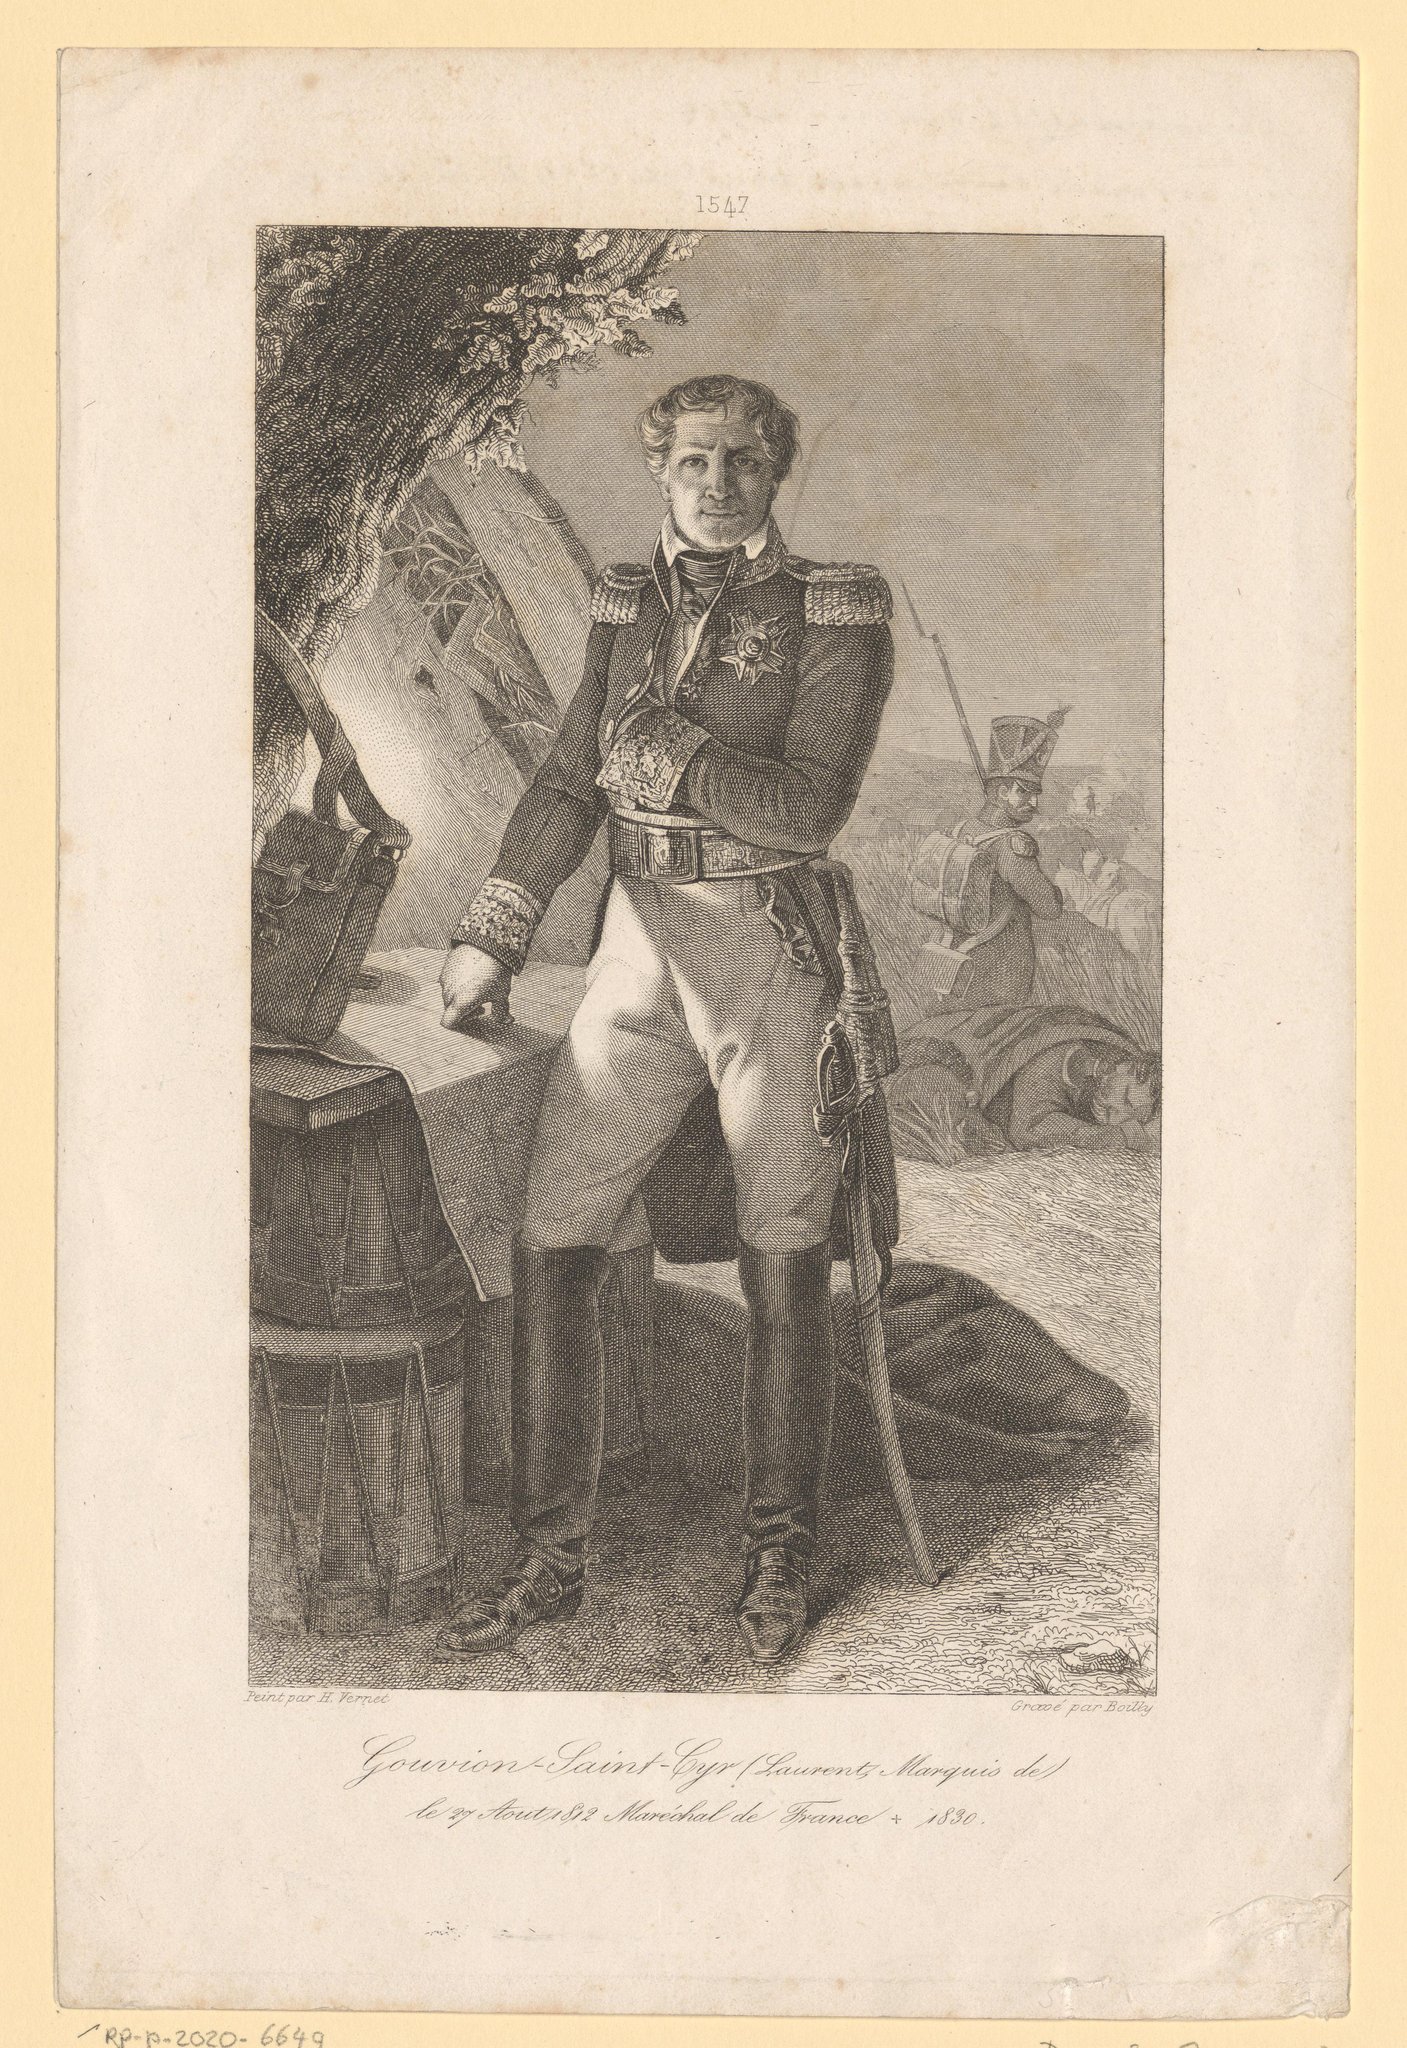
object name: print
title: Portret van Laurent de Gouvion Saint-Cyr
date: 1830-1874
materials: paper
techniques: engraving, etching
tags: historical persons, officer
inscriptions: tekst, verso, handgeschreven